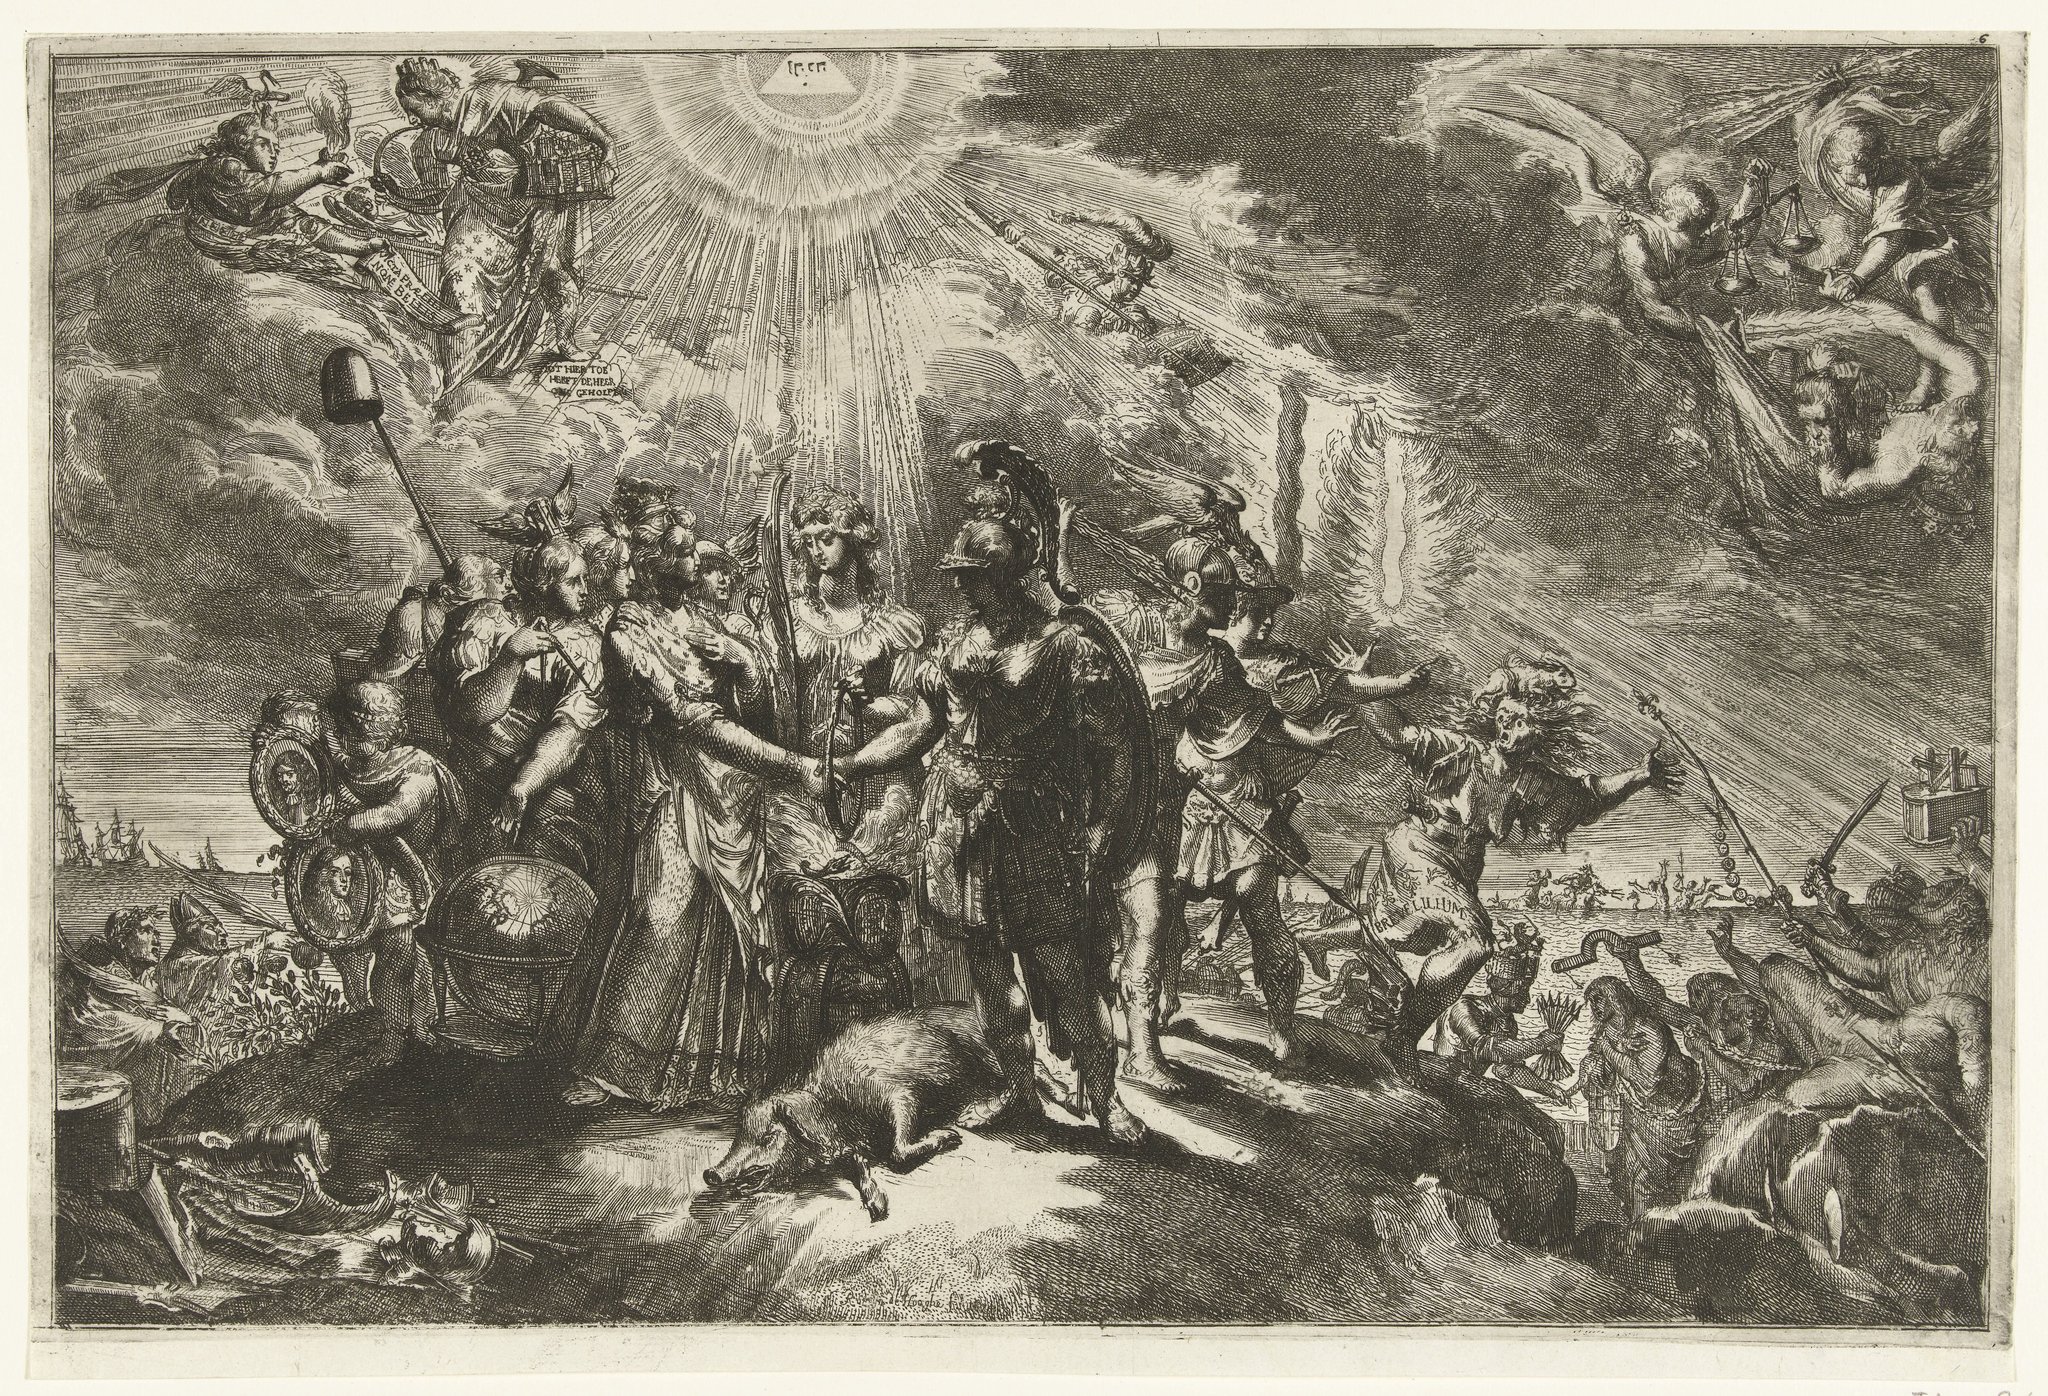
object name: print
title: Nederland sluit eeuwige vrede met Engeland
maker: romeyn de hooghe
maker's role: draughtsman, goldsmith, painter, print maker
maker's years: 1645-1708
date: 1674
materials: paper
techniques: engraving, etching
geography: amsterdam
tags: signing of peace treaty, concluding the peace, rampjaar (disaster year)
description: Nederland sluit bij een altaar de eeuwige vrede met Engeland in 1674. Aan hun voeten ligt een zwijn, als symbool voor de verwoestingen van de oorlog met Frankrijk. De Franse tirannie (met haas) vlucht angstig weg. In de hemel de stralende tetragram, rechtsonder wordt de provincie Utrecht weer verenigd met de Unie. Allegorie op de politieke situatie in de Republiek in het jaar 1674. Genummerd rechtsboven 6.